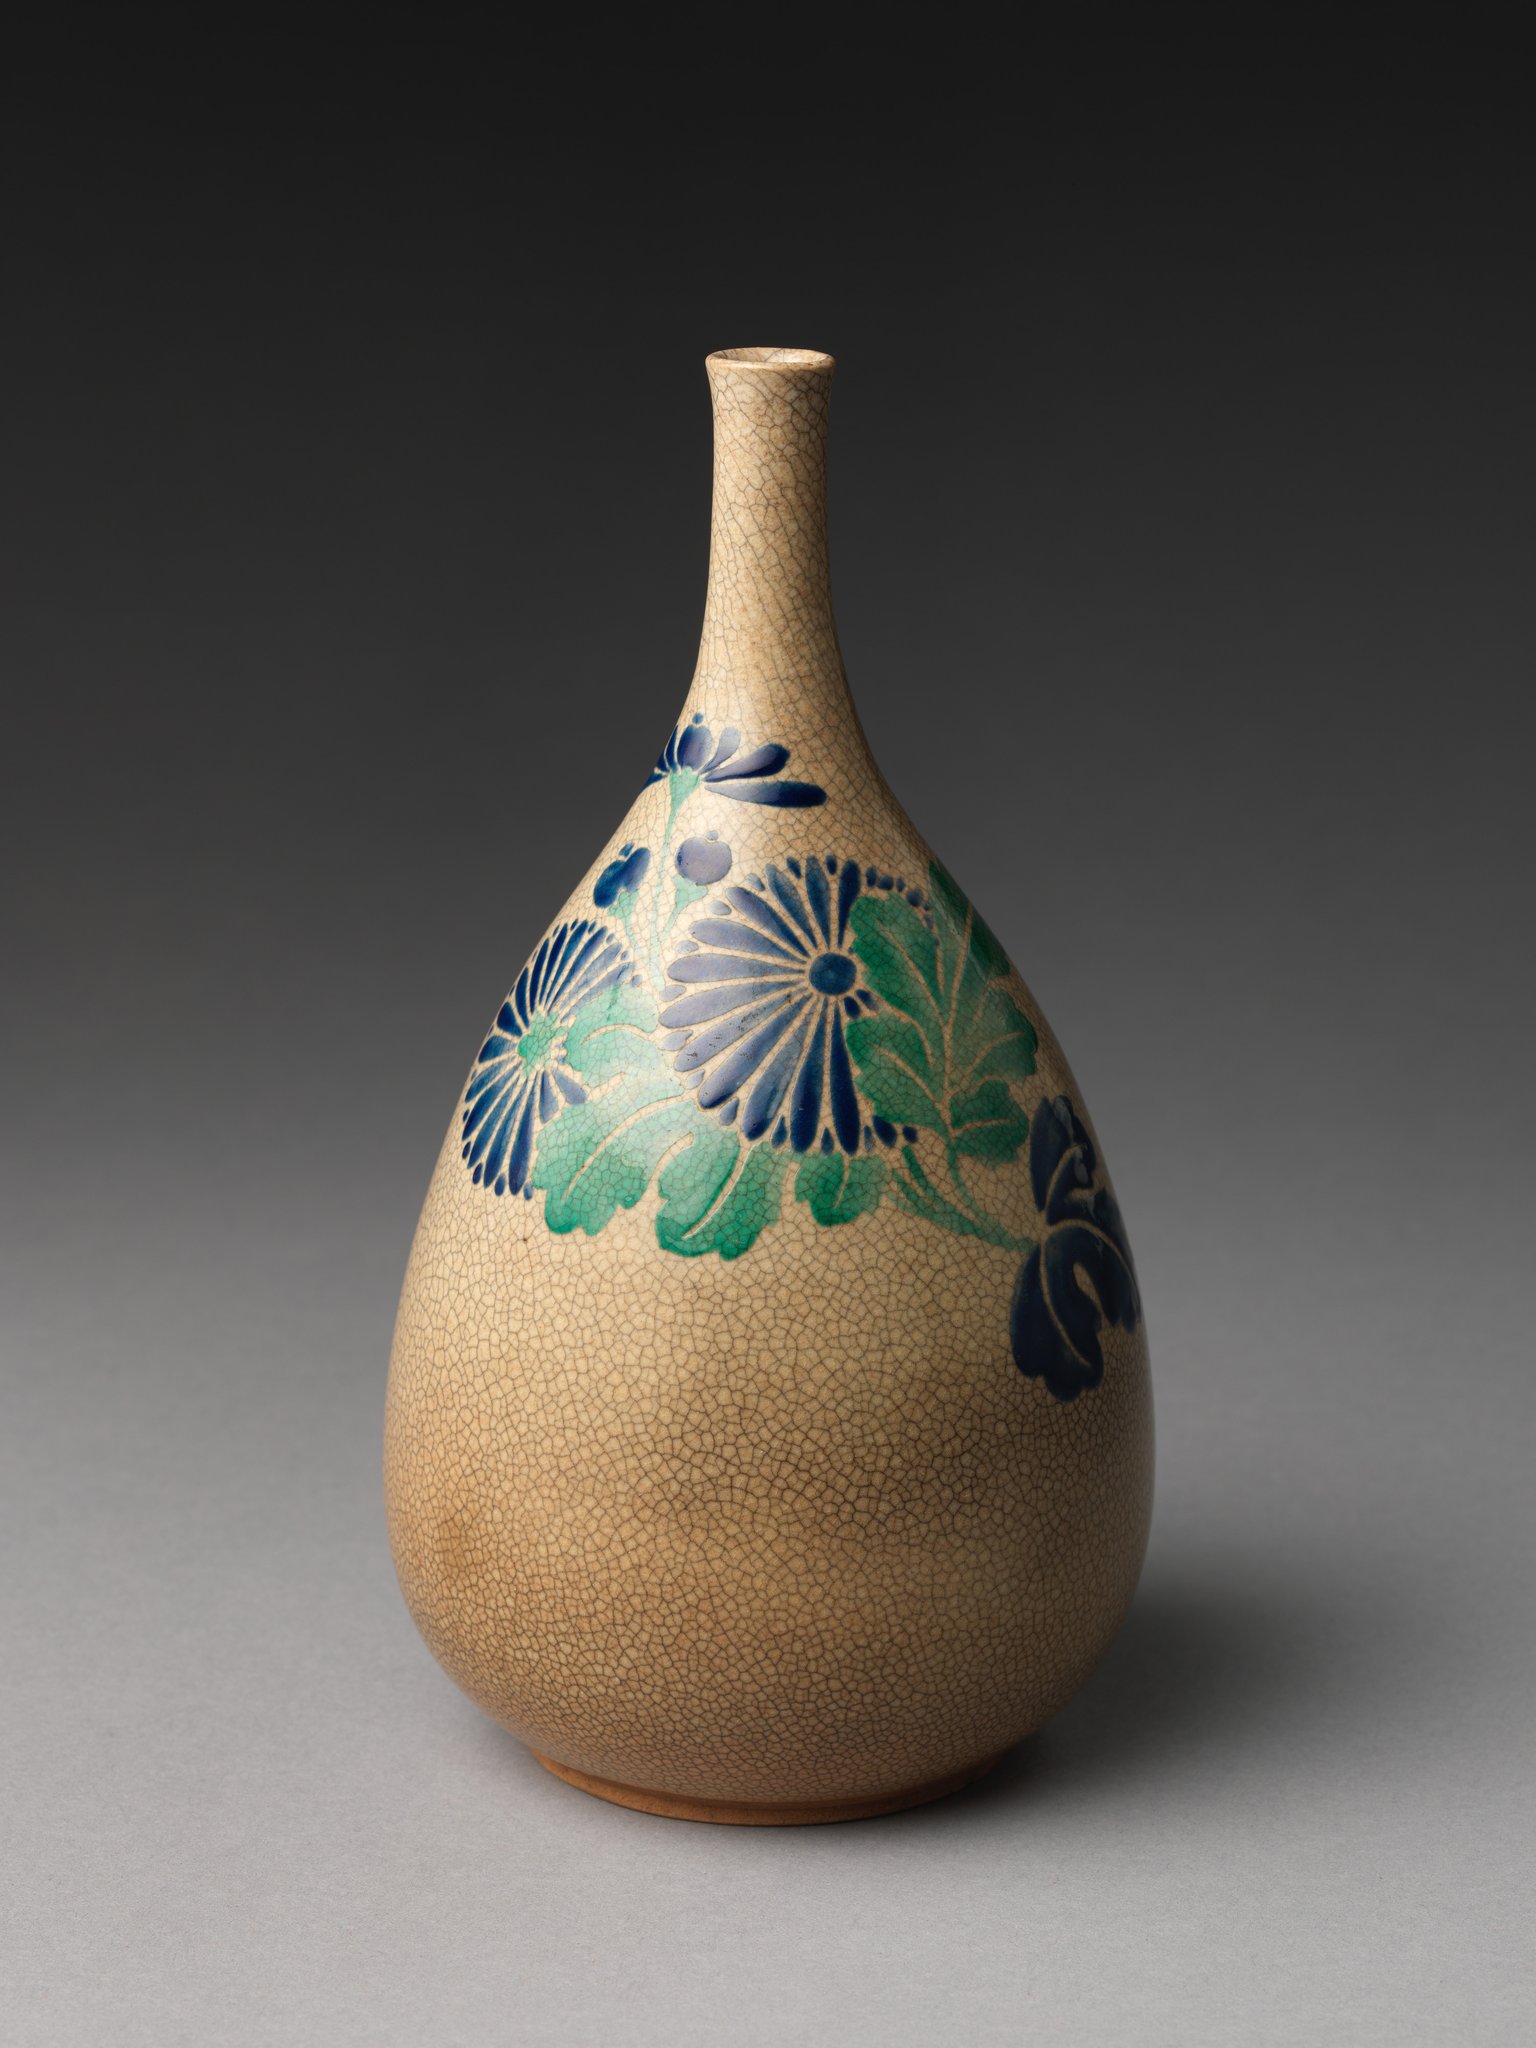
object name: sake bottle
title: Sake bottle with chrysanthemums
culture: japanese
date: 1701-1800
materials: stoneware